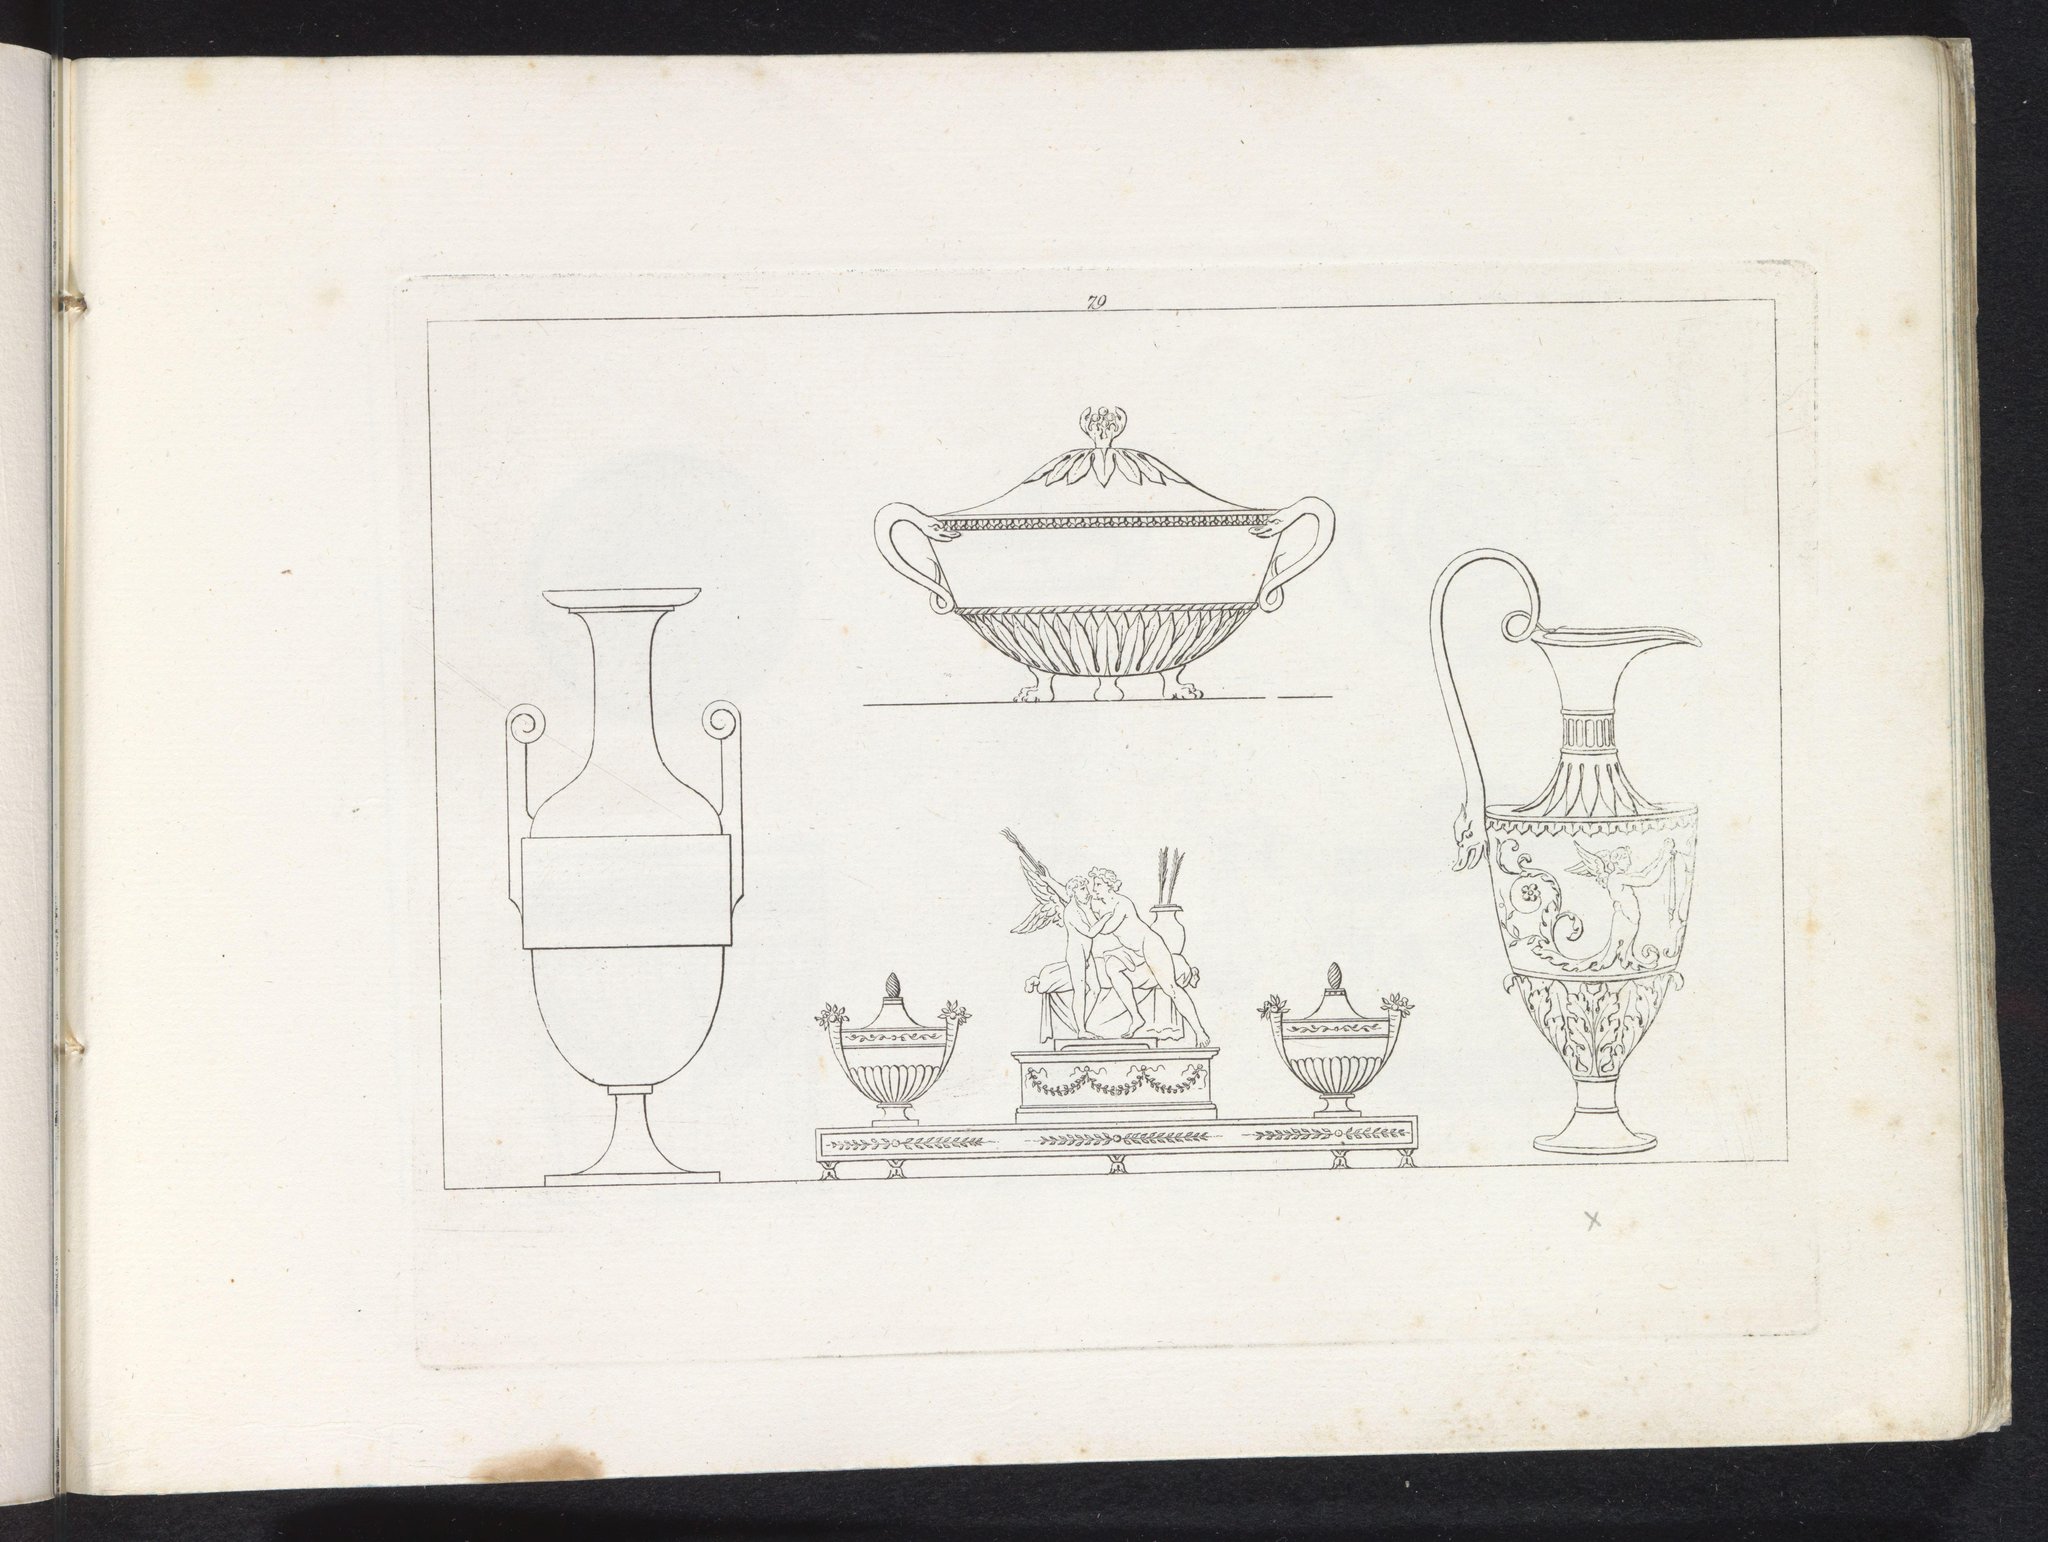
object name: album leaf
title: Vaas, schaal, kan, urnen en een sculptuur van Venus en Amor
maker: pietro ruga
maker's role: print maker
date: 1817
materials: paper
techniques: etching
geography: italy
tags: ornaments ~ art, vase ~ ornament, jar, jug (used as drinking-vessel), piece of sculpture, reproduction of a piece of sculpture, bowl, urn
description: Prent maakt deel uit van een reeks van 100 prenten (+ titelprent) met ontwerpen voor religieuze en profane voorwerpen.